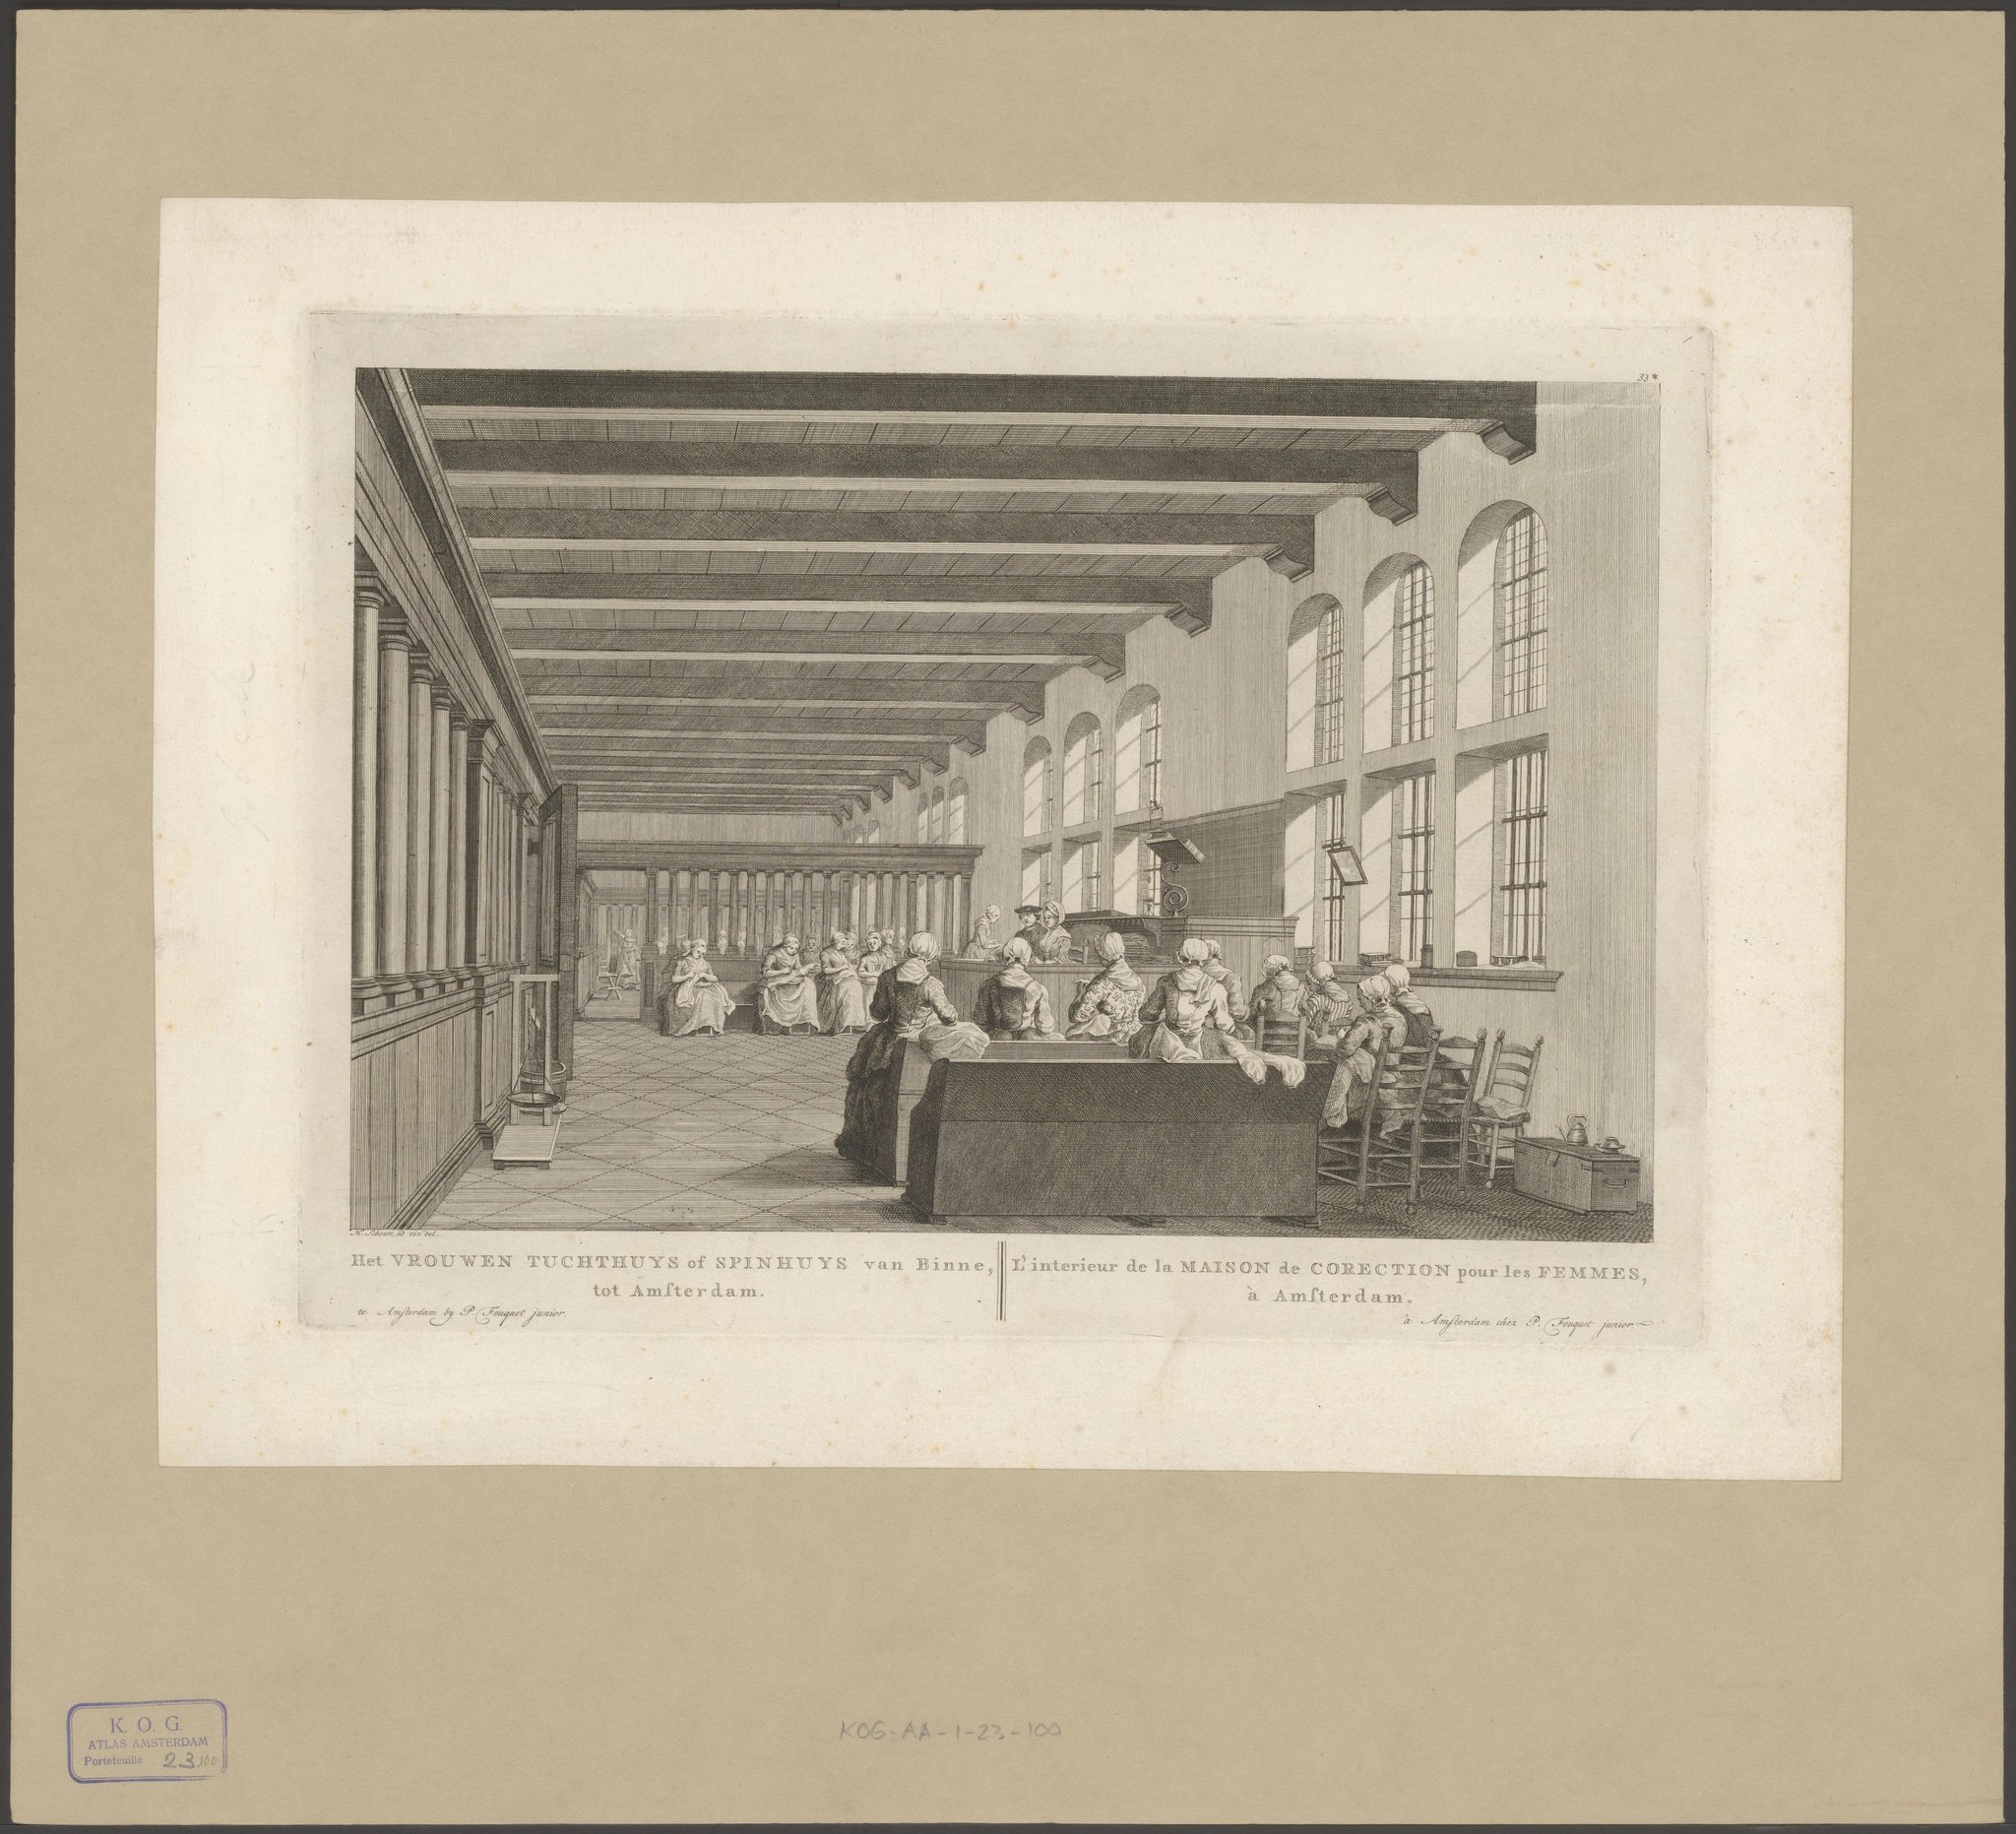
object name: print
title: Het Vrouwen Tuchthuys of Spinhuys van binne, tot Amsterdam / L'interieur de la Maison de Corection pour les femmes, à Amsterdam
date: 1770-1783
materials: paper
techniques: engraving, etching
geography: amsterdam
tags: prison, jail, workhouse, penal camp, penitentiary, chain gang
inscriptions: collector's mark: Lugt 1641b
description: Vanaf 1760 gaf Pierre Fouquet stadsgezichten van Amsterdam naar tekeningen van verschillende kunstenaars uit. Deze prenten werden aanvankelijk los verkocht. Later werden ze samengebonden verkocht in verschillende volgordes en aantallen in: (1). Afbeeldingen van de wyd-vermaarde koopstad Amsterdam benevens des zelvs voornaamste gebouwen en gezigten alle naar het leeven getekend / Receuil des edifices les plus considerables et des plus belles vues, de la fameuse ville d'Amsterdam, dessinées d'après nature. Amsterdam: Pierre Fouquet, 1778-1783. Deze 'uitgave' bestond waarschijnlijk alleen uit een titelblad en inhoudsopgave van de tot dusver 100 uitgegeven prenten, die de koper zelf aan zijn of haar reeds verzamelde prenten kon toevoegen. De hoeveelheid en volgorde van prenten verzameld onder deze titel verschilt dus sterk. (2). Nieuwe atlas, van de voornaamste gebouwen en gezigten der stad Amsterdam, met derzelver beknopte beschryvingen. 2 dln. Amsterdam: Daniël Jean Changuion en Petrus den Hengst [in opdracht van Pierre Fouquet], 1783. Ook werden er door verschillende uitgevers tussen 1788 (Amsterdam: Petrus Conradi) en 1805 (Amsterdam: Evert Maaskamp) heruitgaven gepubliceerd.